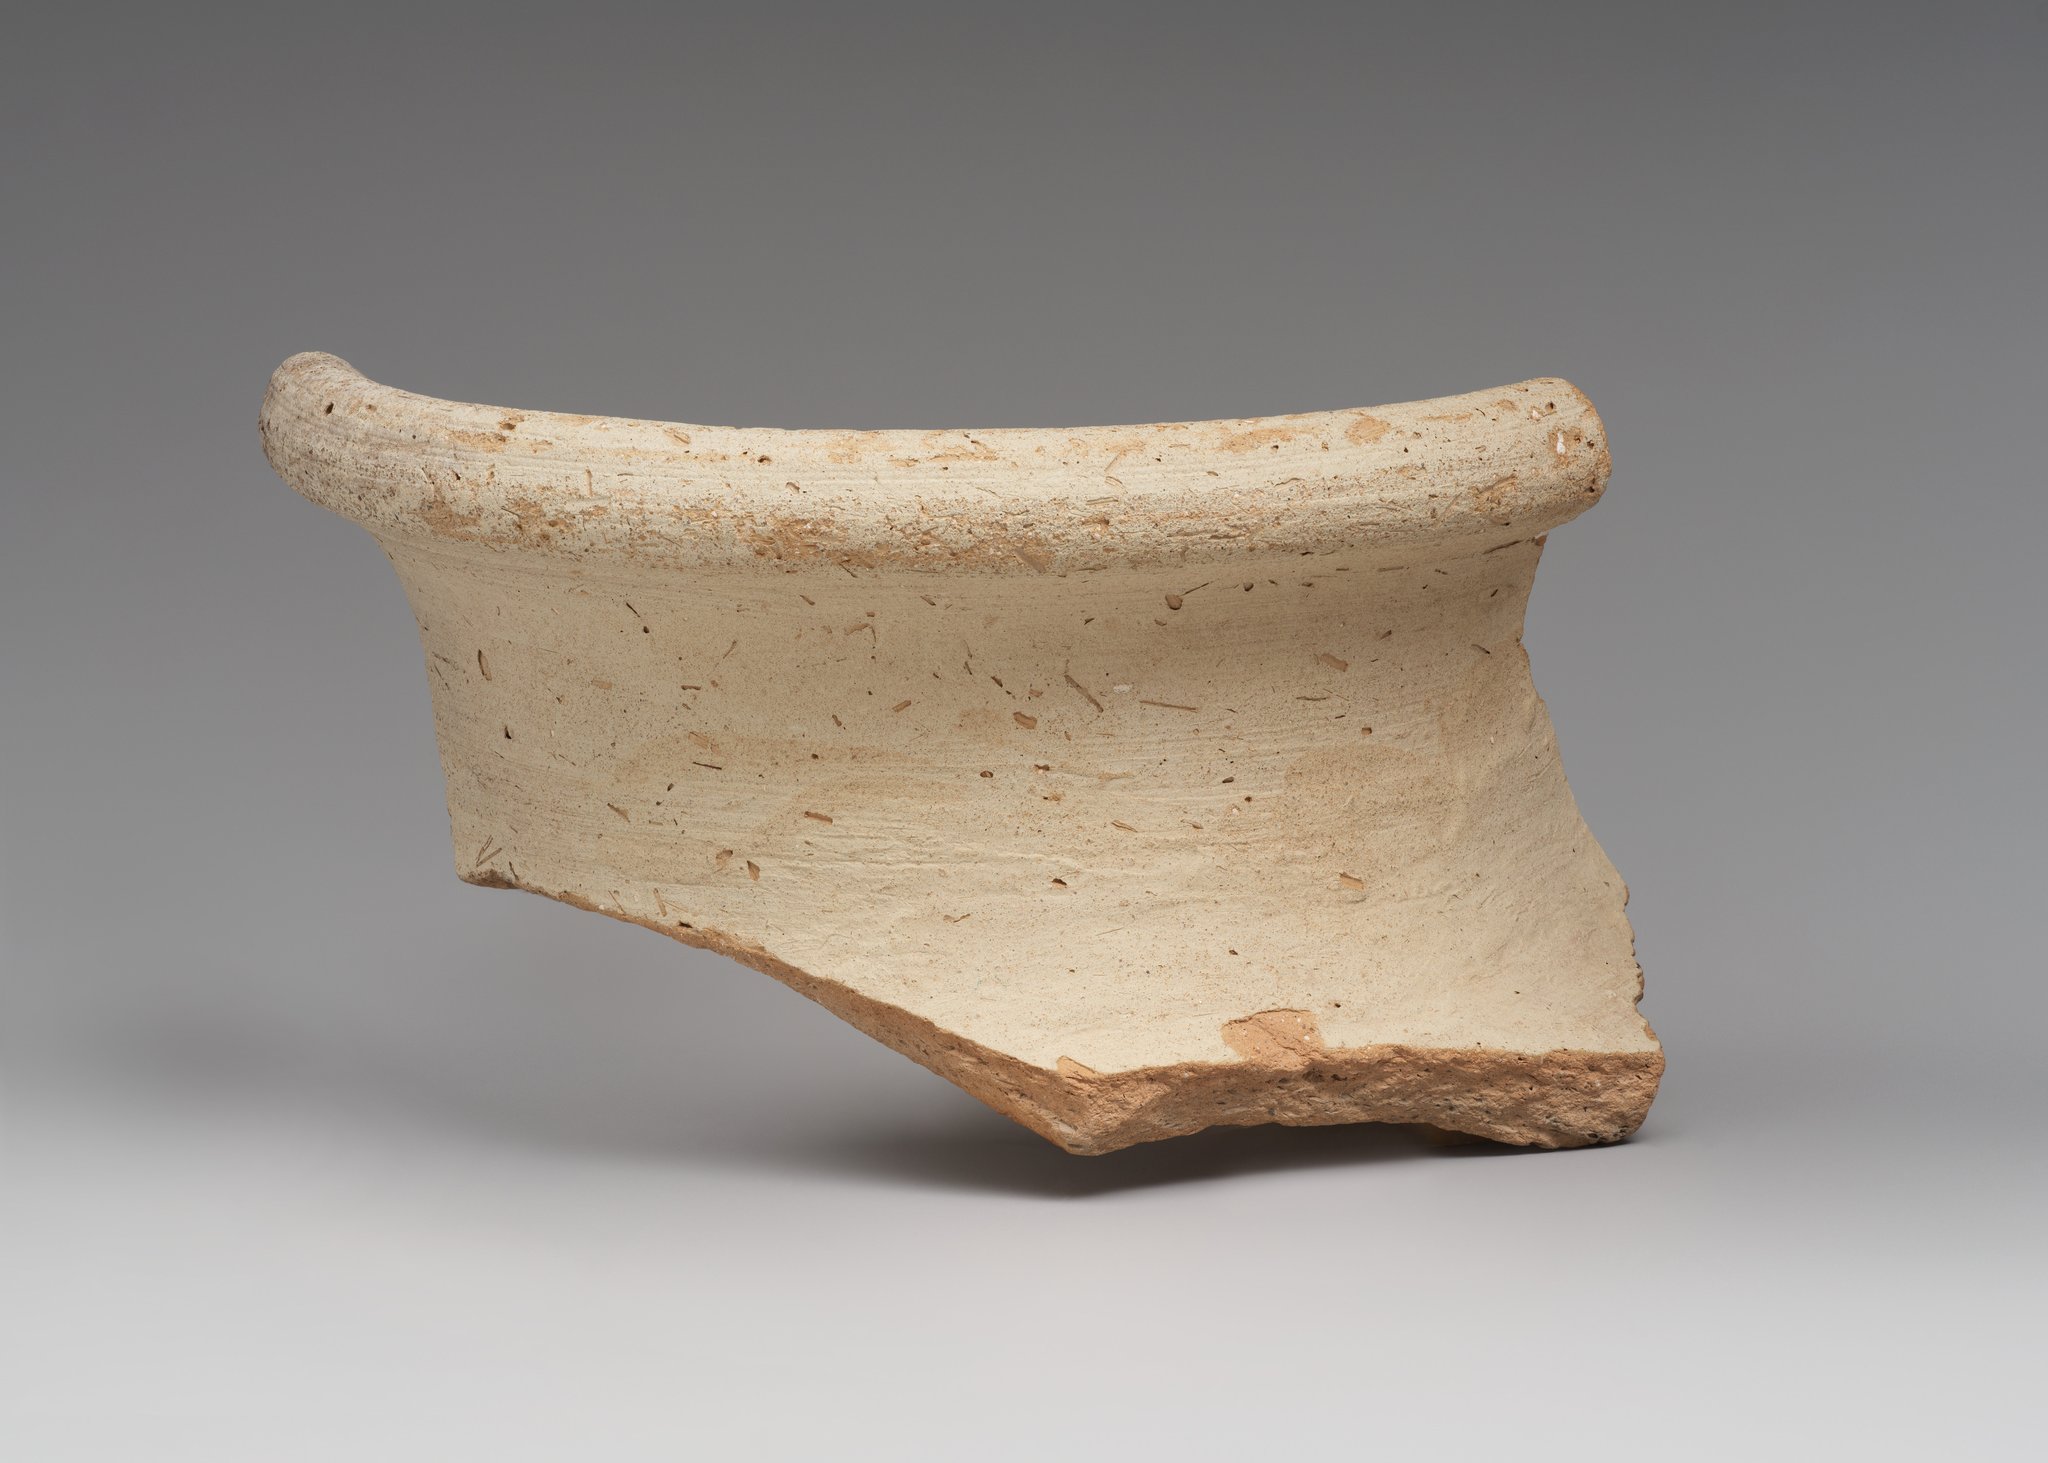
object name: jar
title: Jar rim sherd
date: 2333-2001 BCE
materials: ceramic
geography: mesopotamia